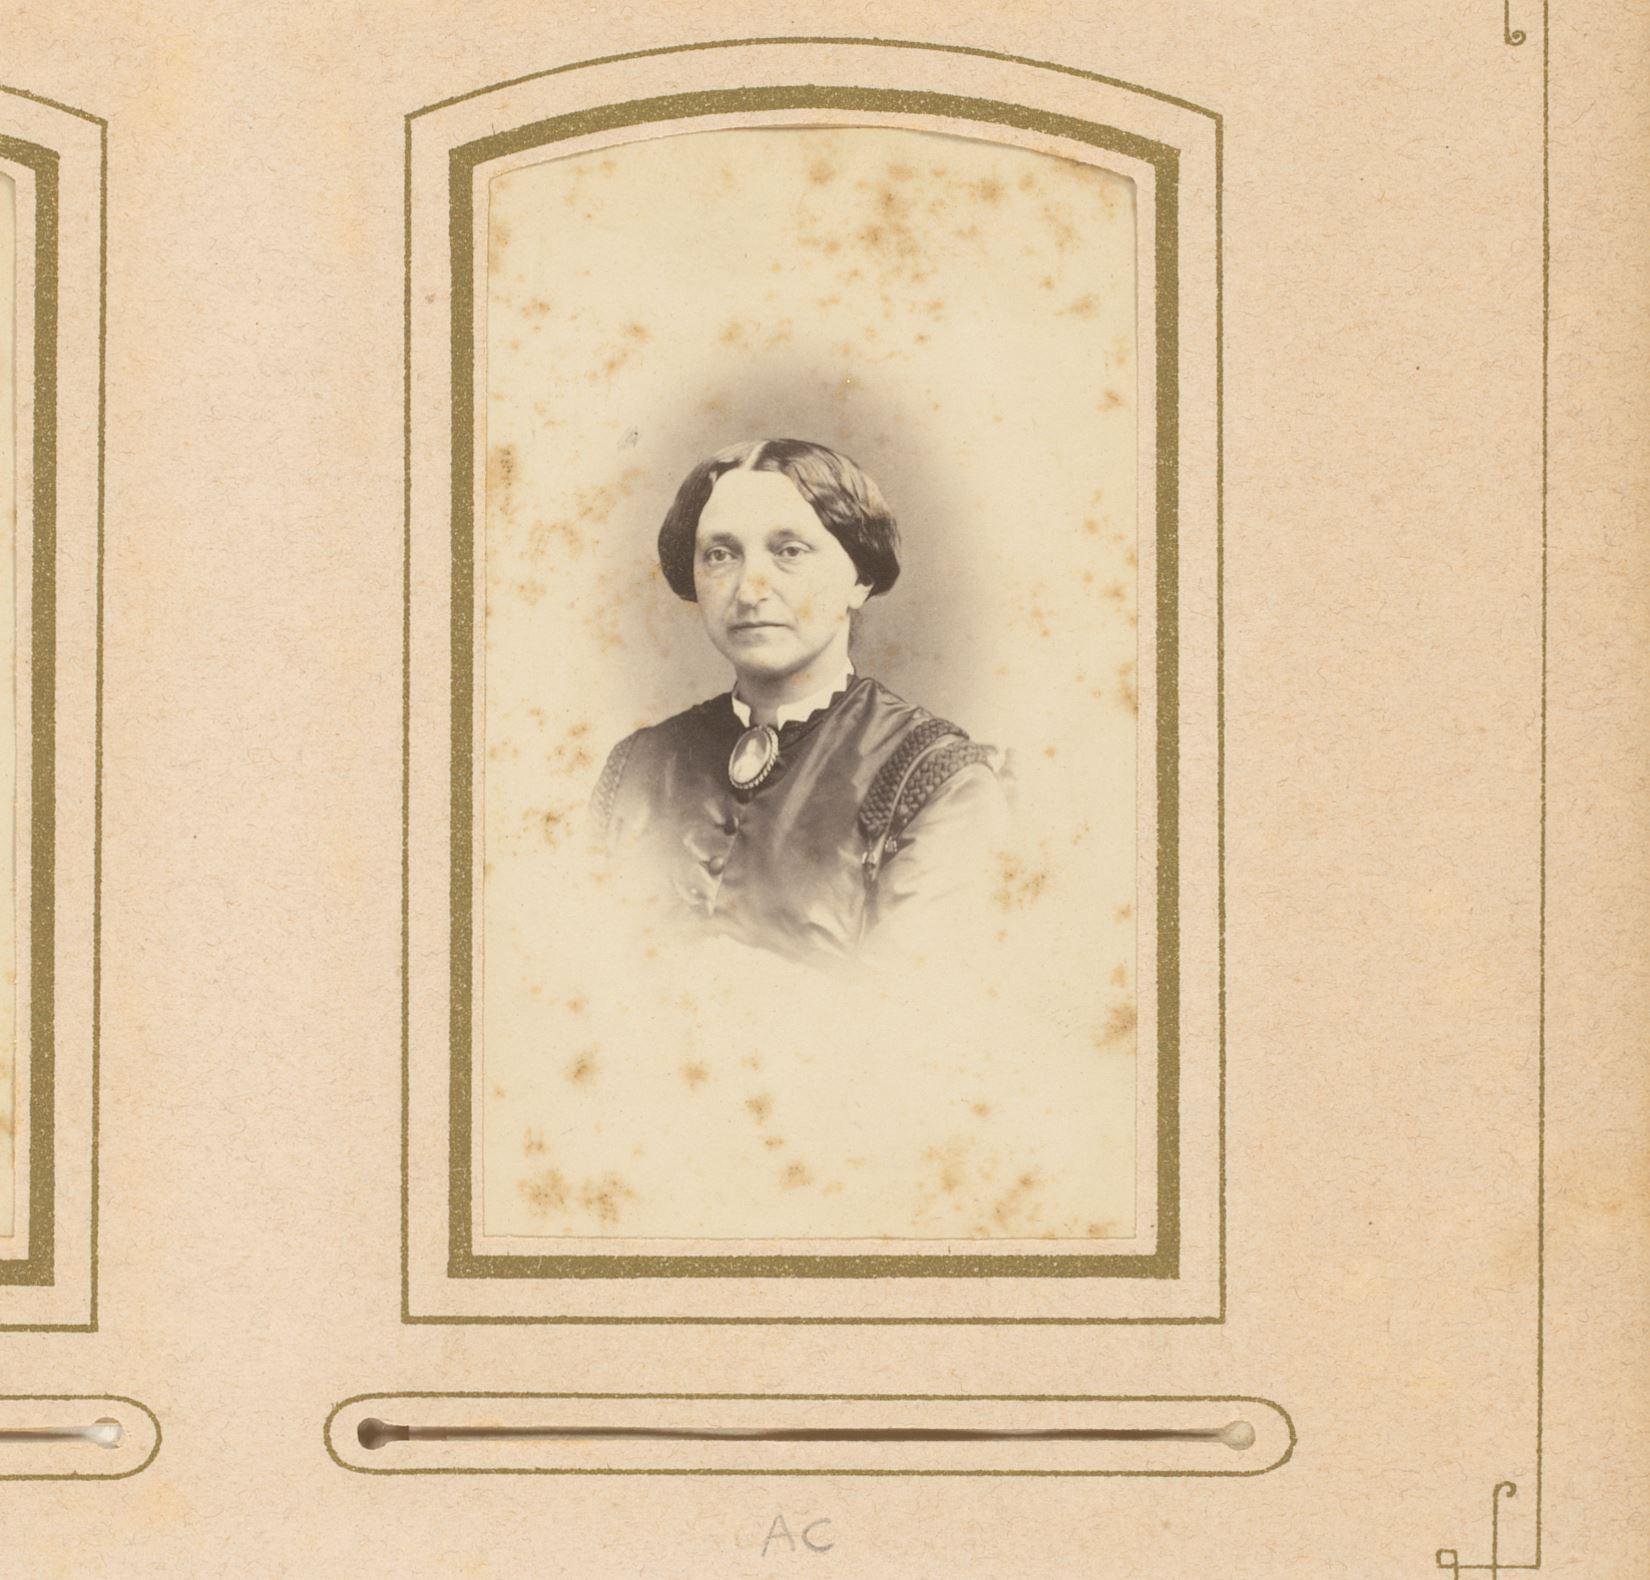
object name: carte de visite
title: Portret van een vrouw met halsketting met medaillon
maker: leonard stollenwerk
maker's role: fotograaf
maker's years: 1829-1910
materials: cardboard, photographic support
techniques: albumen print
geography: den bosch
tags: historical persons - bb - woman, pendant, trinket, 'breloque'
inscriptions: inscription: ‘Photographie/ van/ L. Stollenwerk/ (...)/ Spiegel en LIJSTEN FABRIEK/ SBOSCH.’